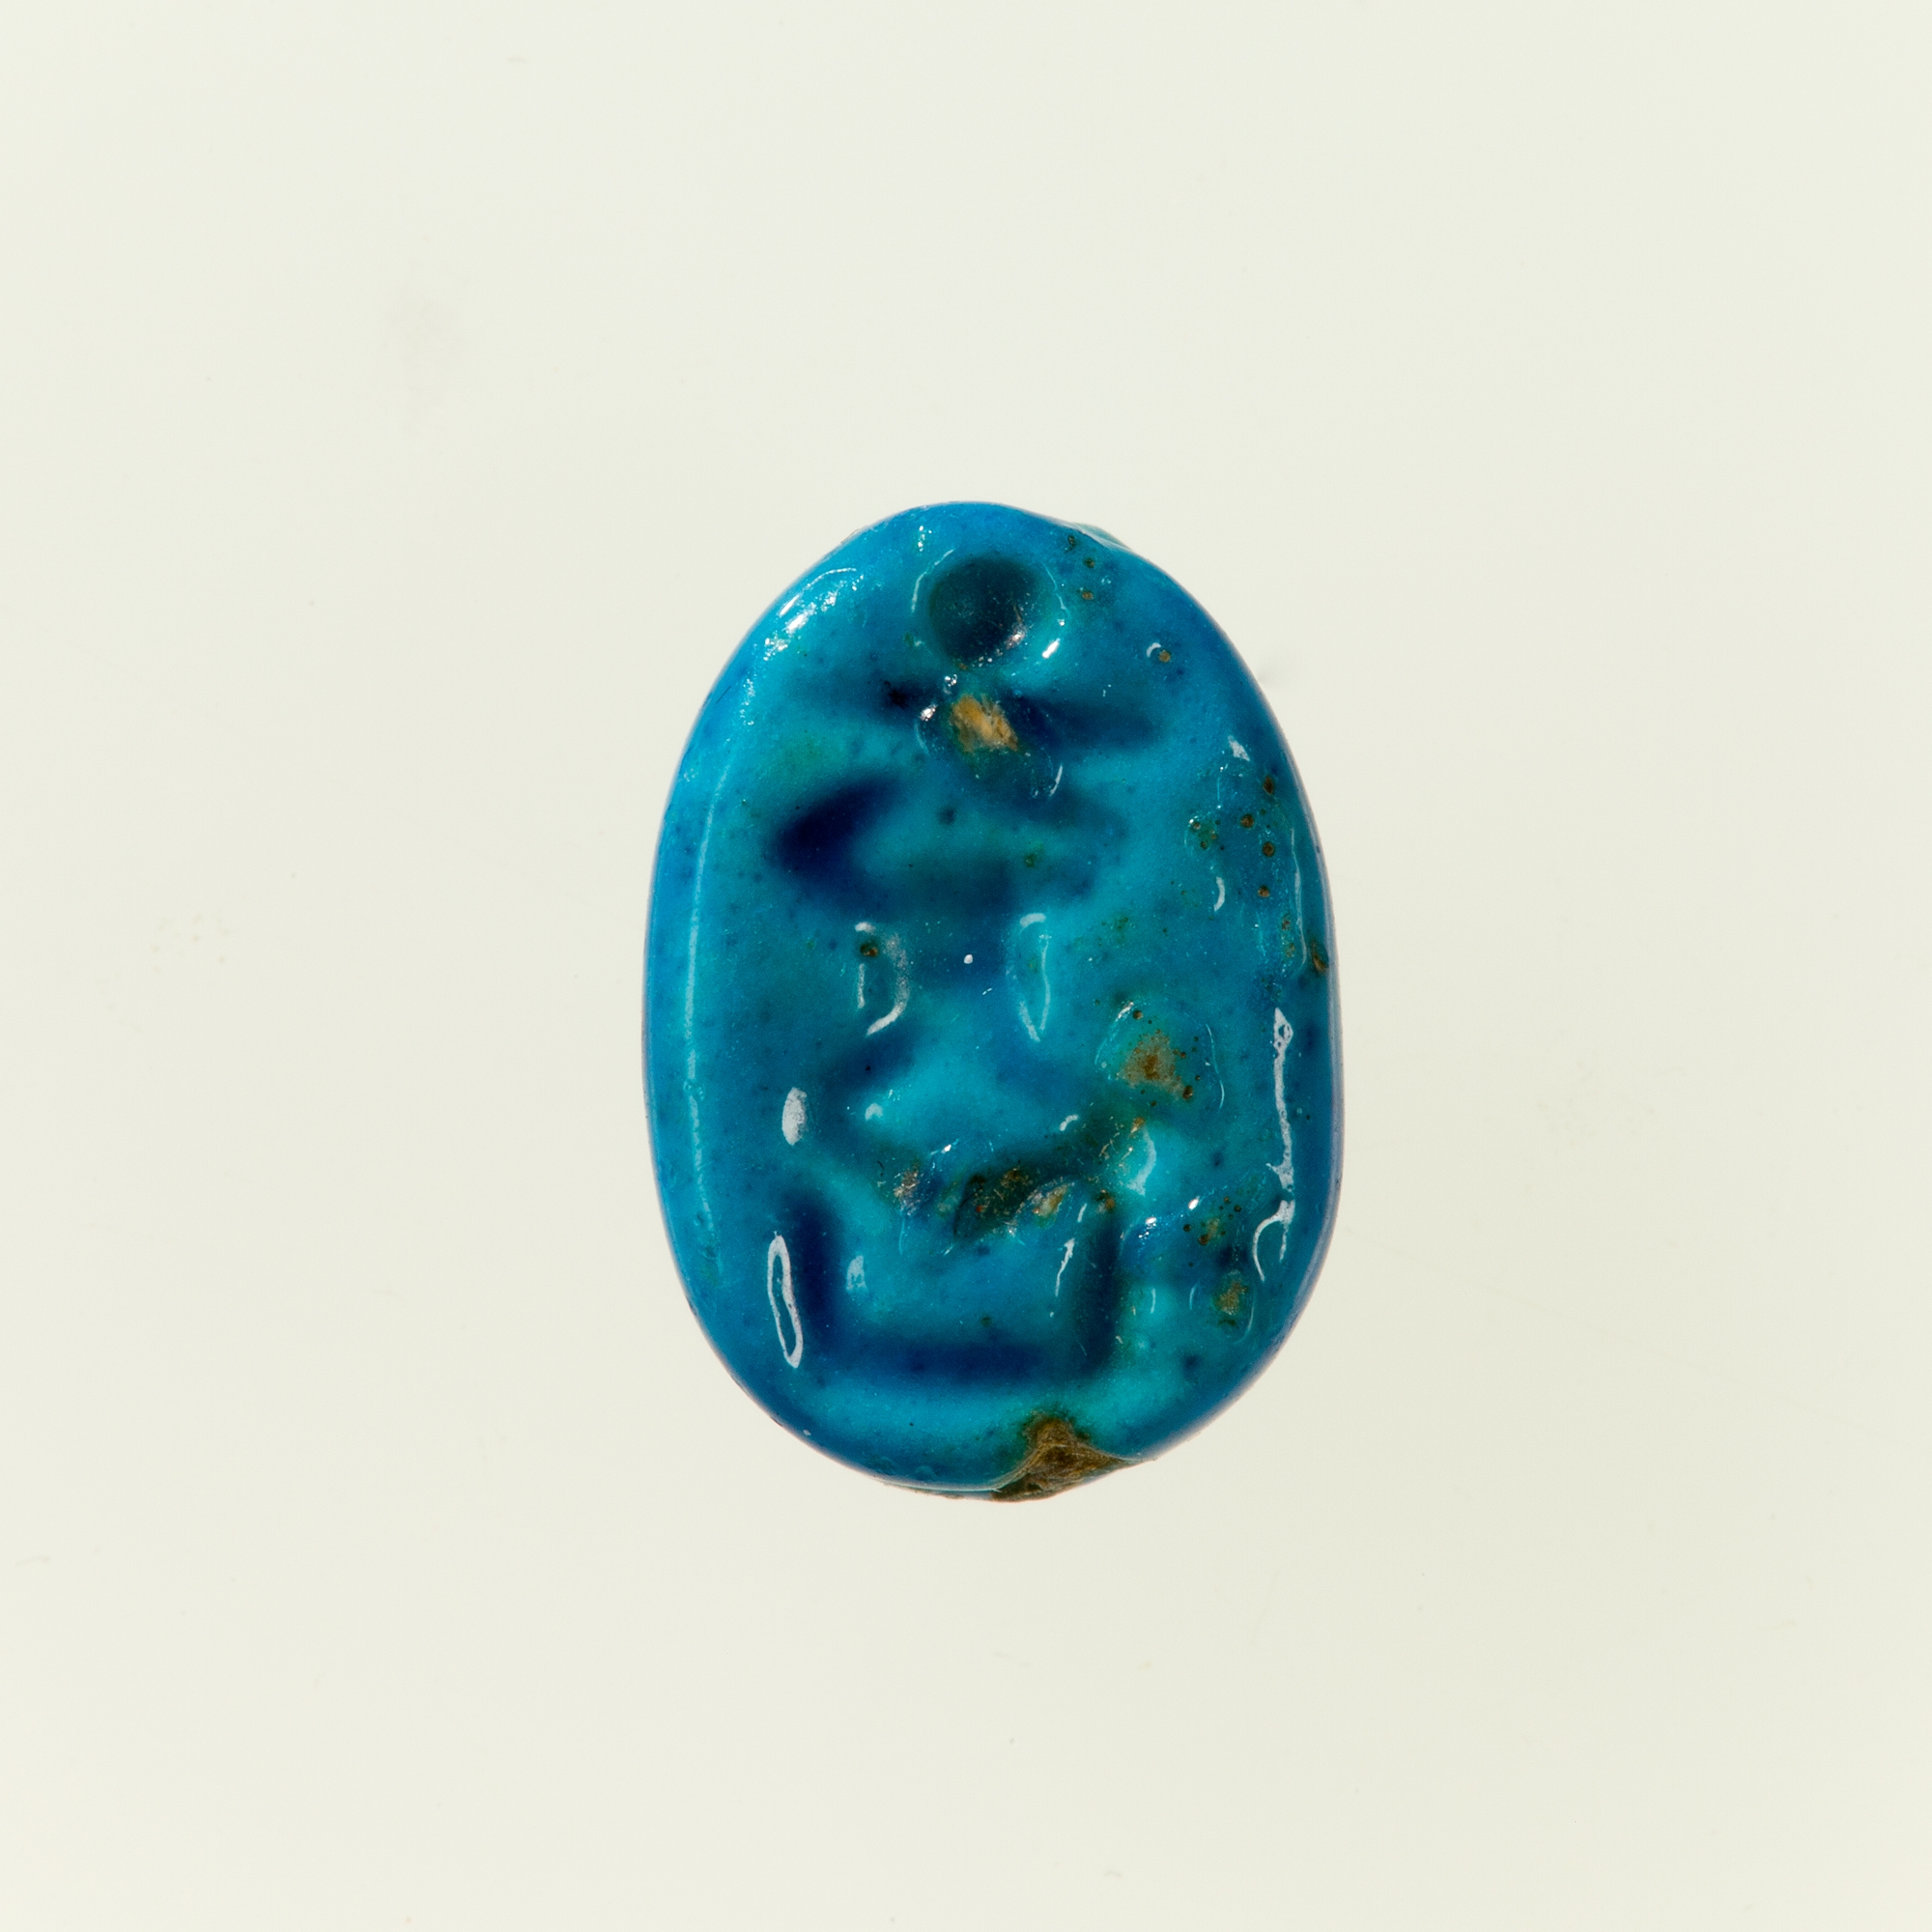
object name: scarab, thutmose i, aakheperkare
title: Scarab with the name Aakheperkare (Thutmose I)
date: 1504-1492 BCE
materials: faience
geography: egypt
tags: hieroglyphs,scarabs